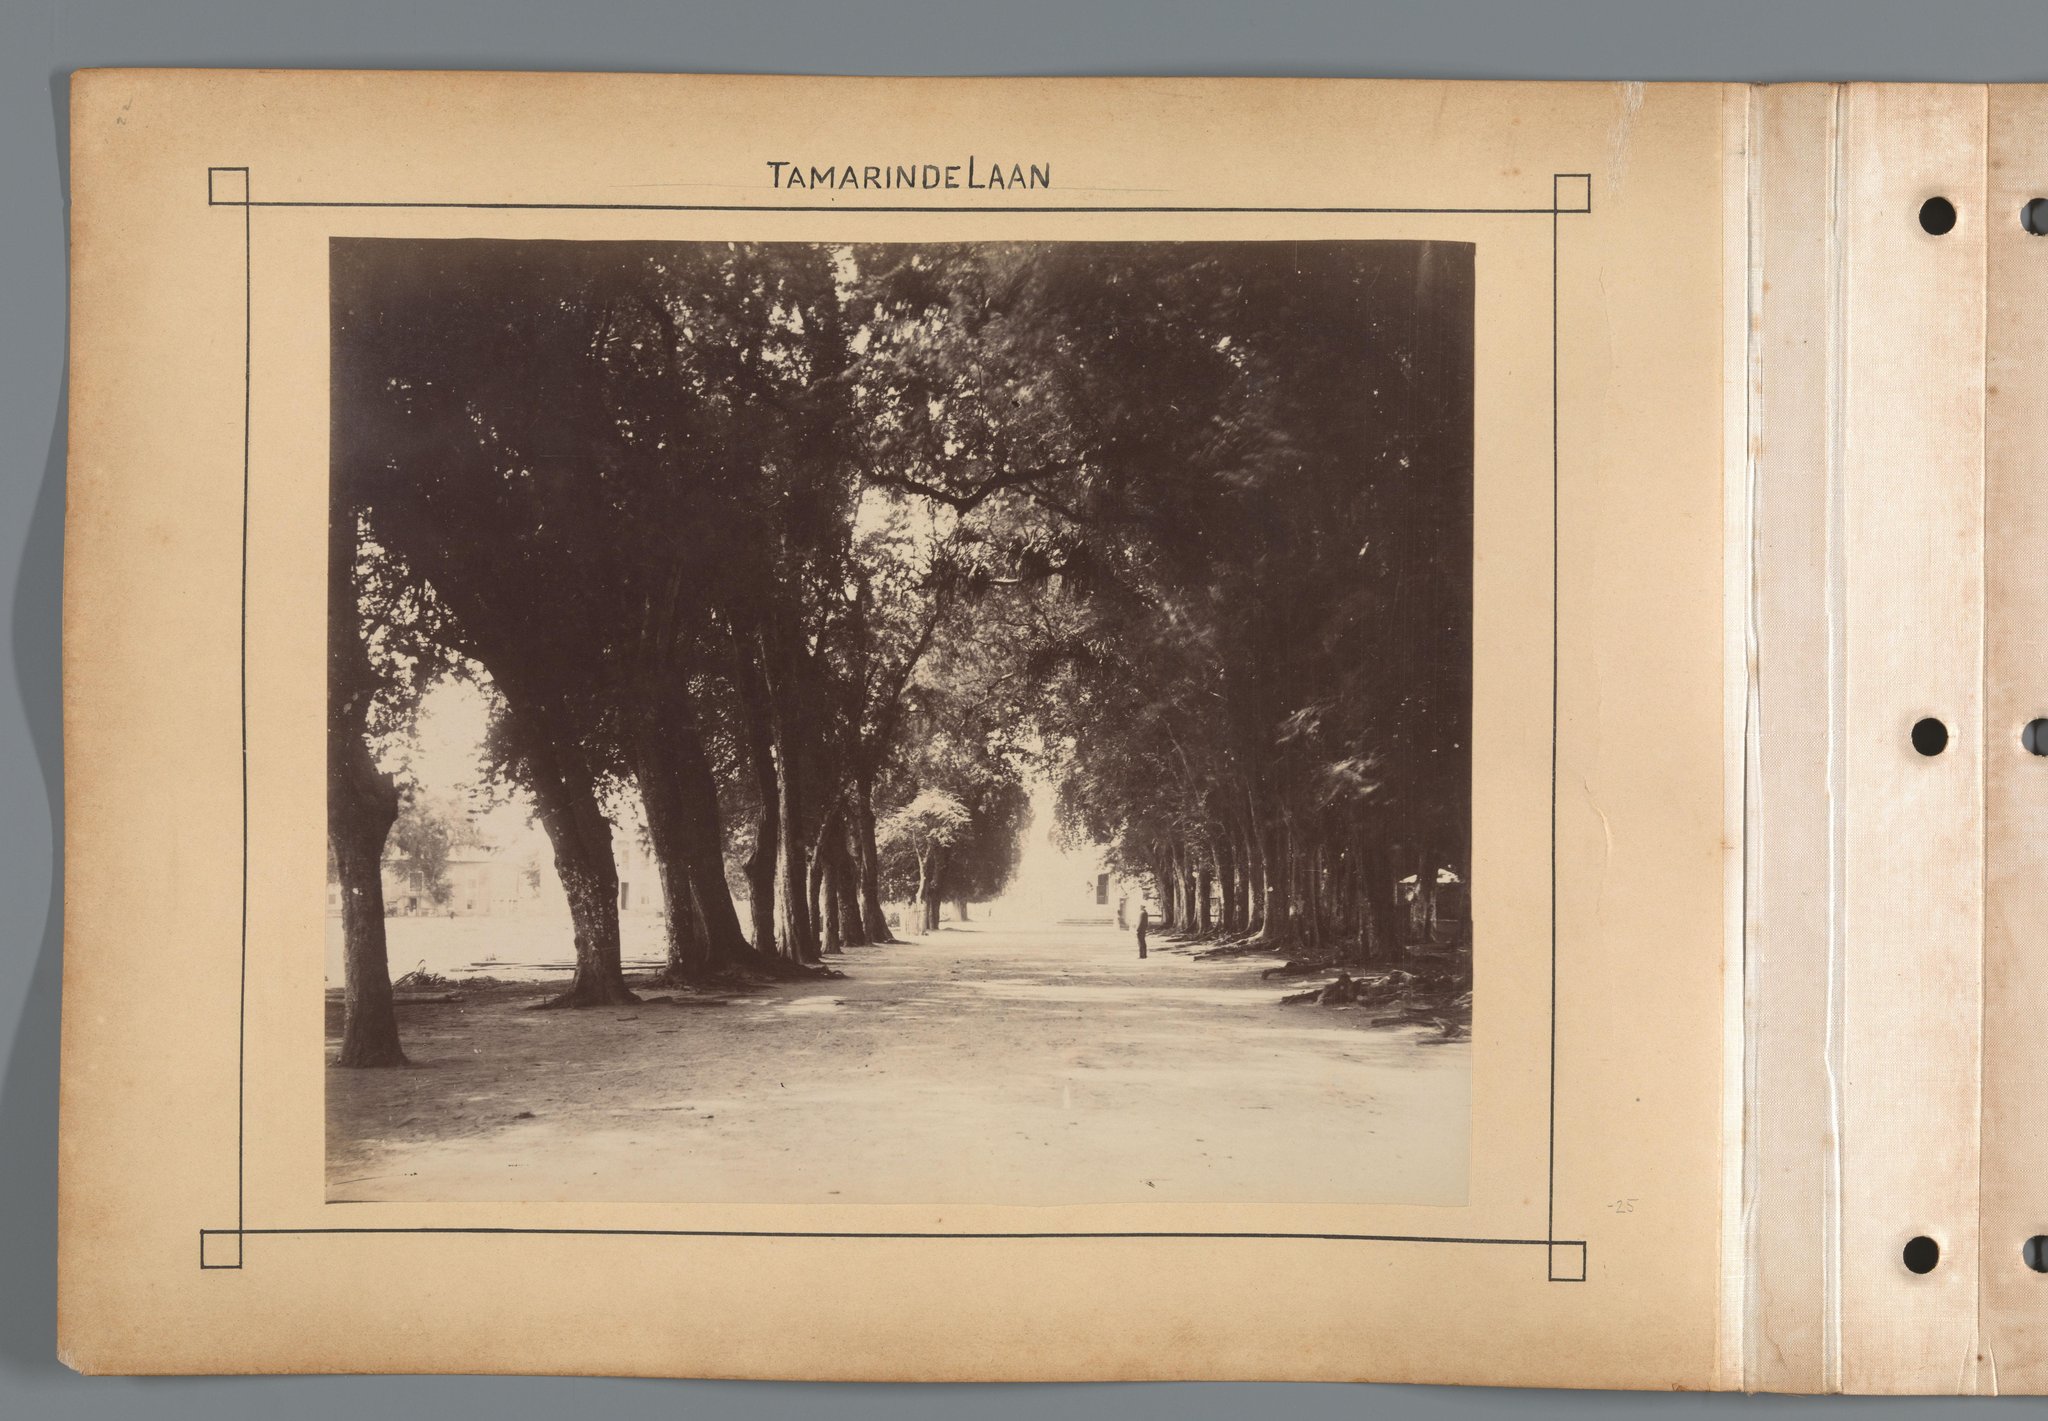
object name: photograph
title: Tamarindelaan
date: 1898-1902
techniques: albumen print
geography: suriname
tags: suriname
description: Tamarindelaan met aan weerszijden bomen, Paramaribo.